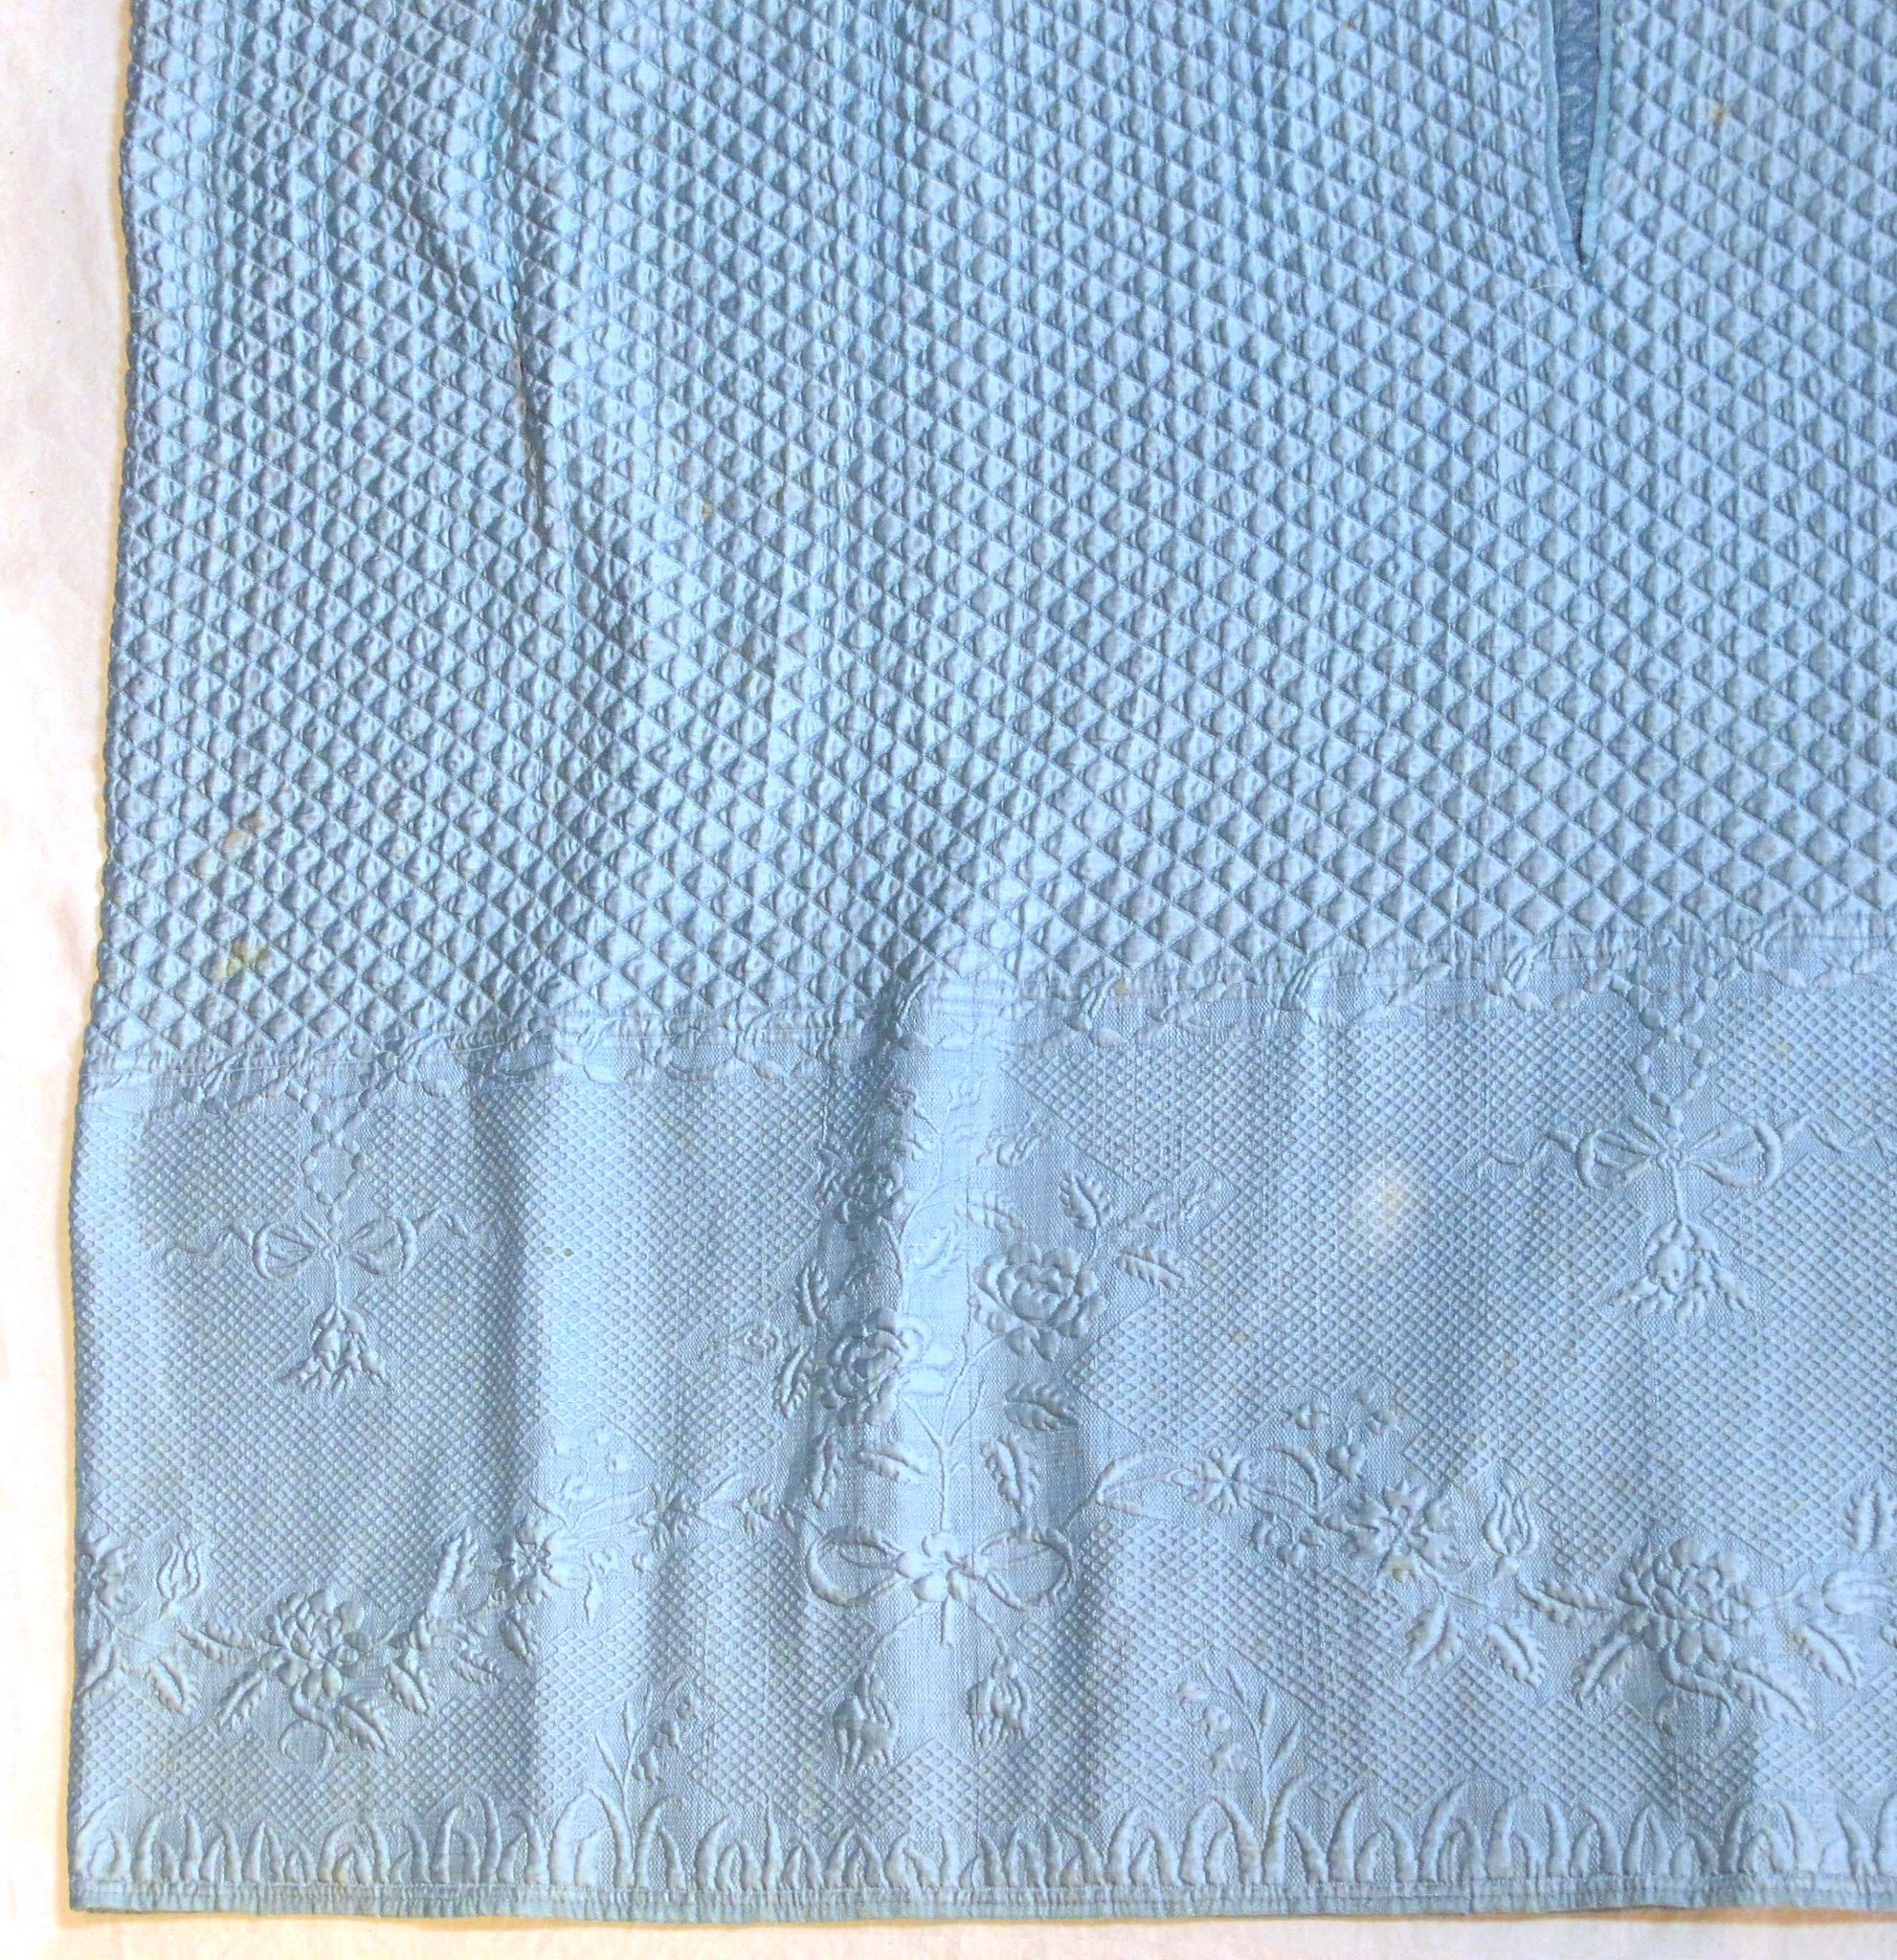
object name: petticoat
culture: british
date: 1760-1780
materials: cotton, silk